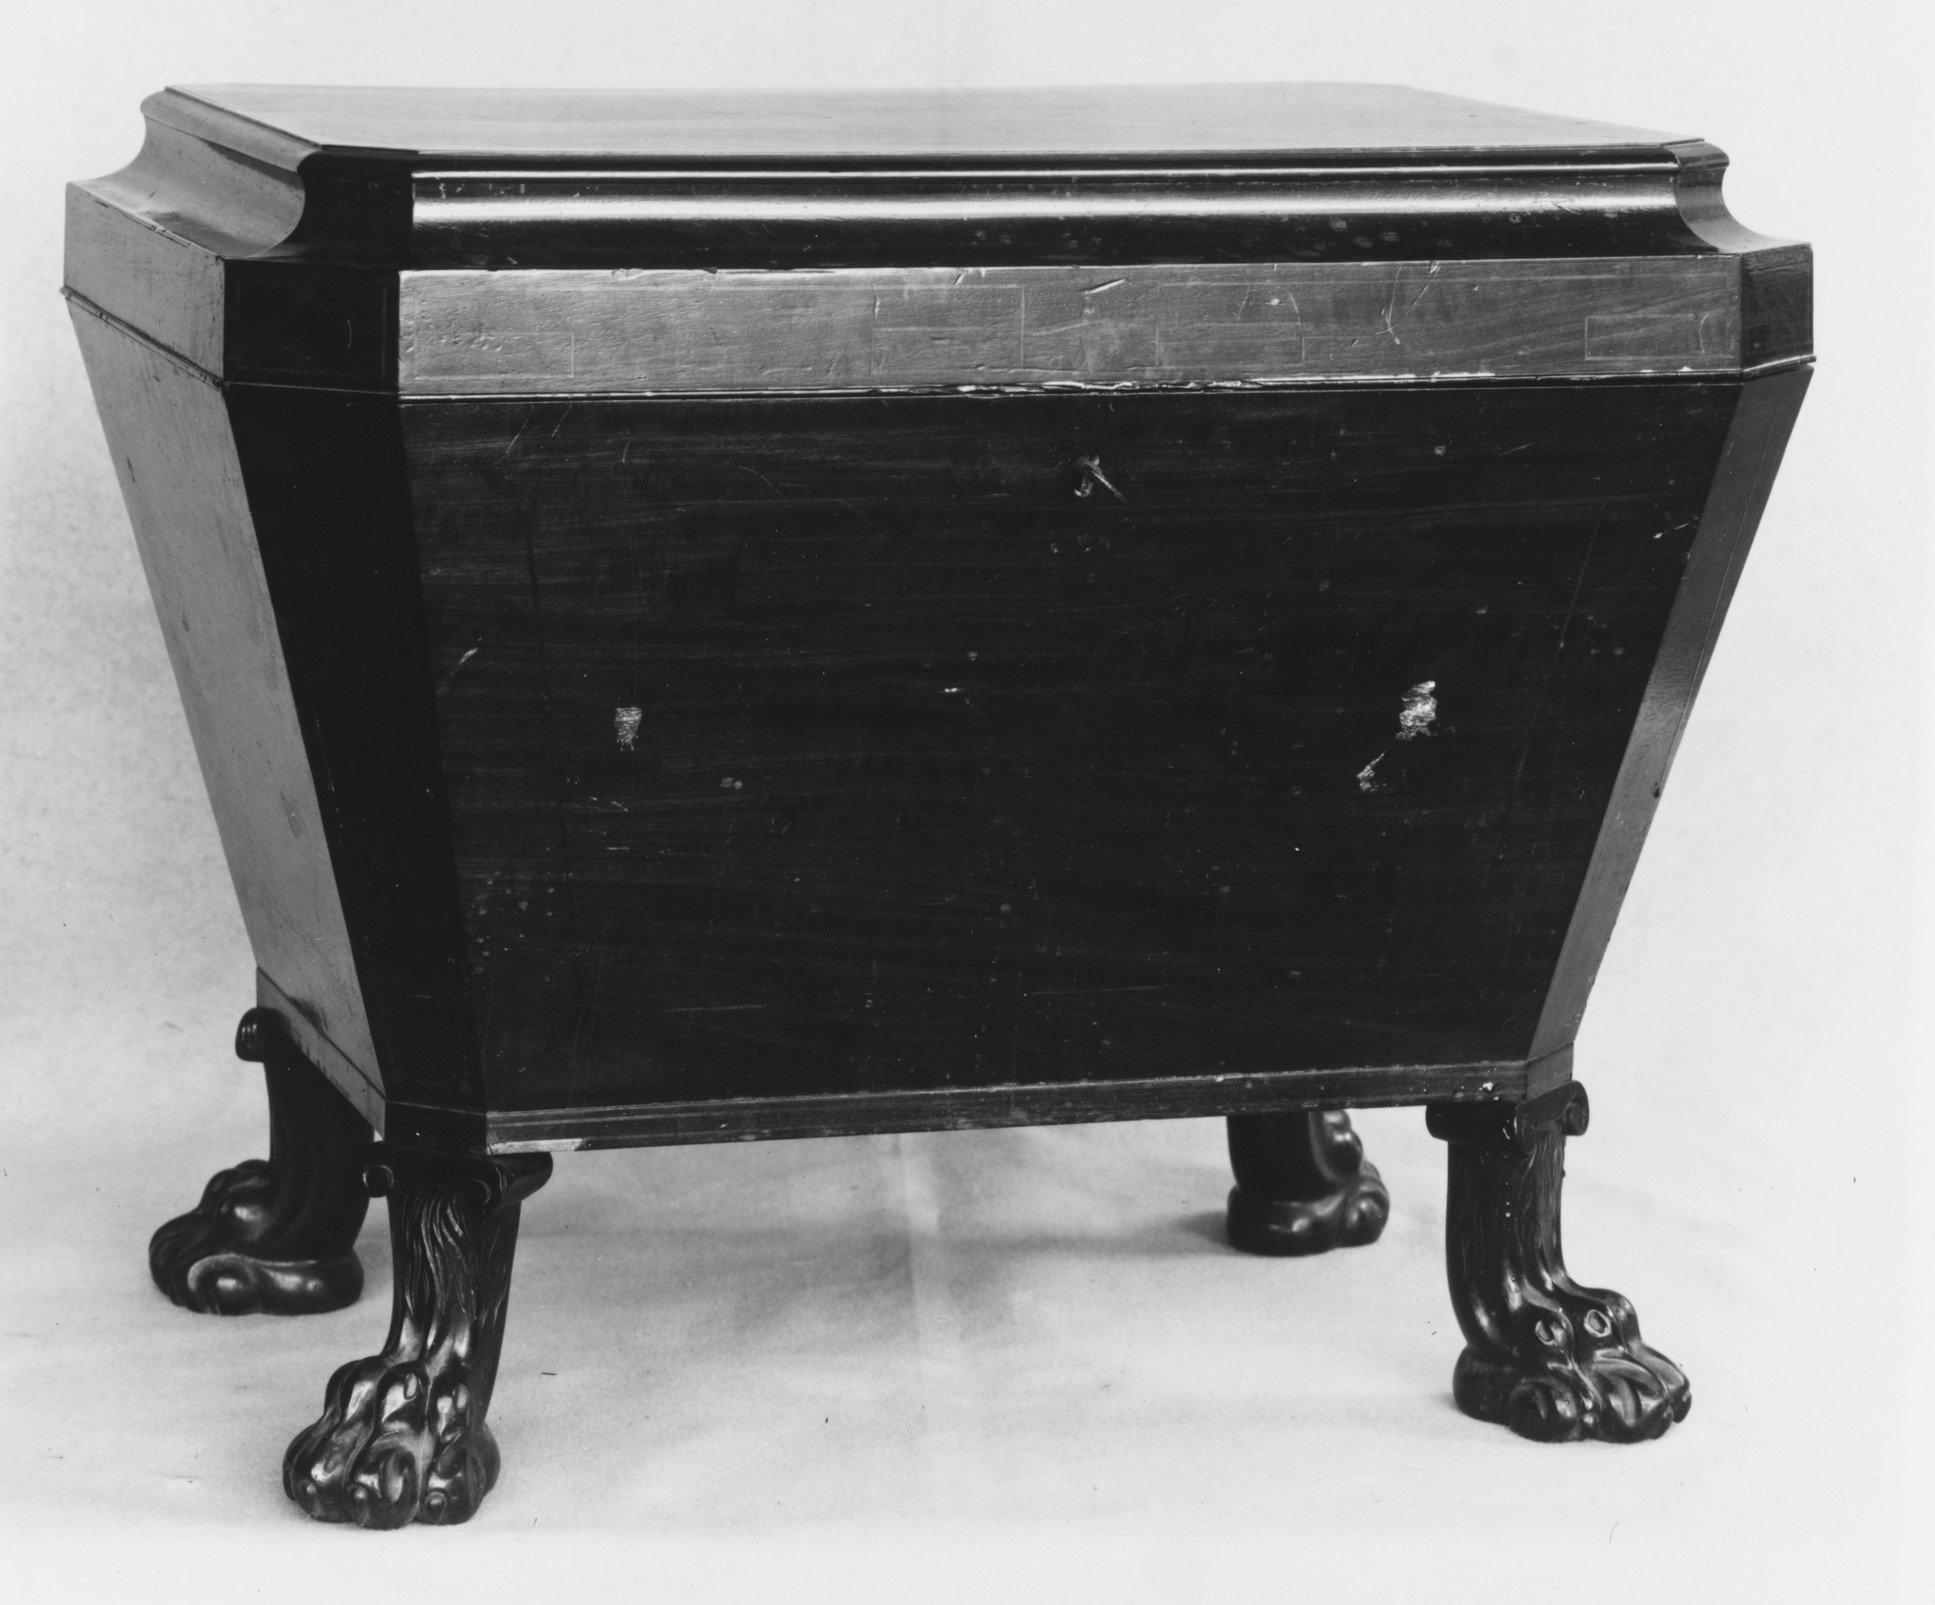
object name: cellaret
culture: american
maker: duncan phyfe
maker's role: maker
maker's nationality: american, born scotland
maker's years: 1770-1854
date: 1800-1830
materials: wood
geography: united states